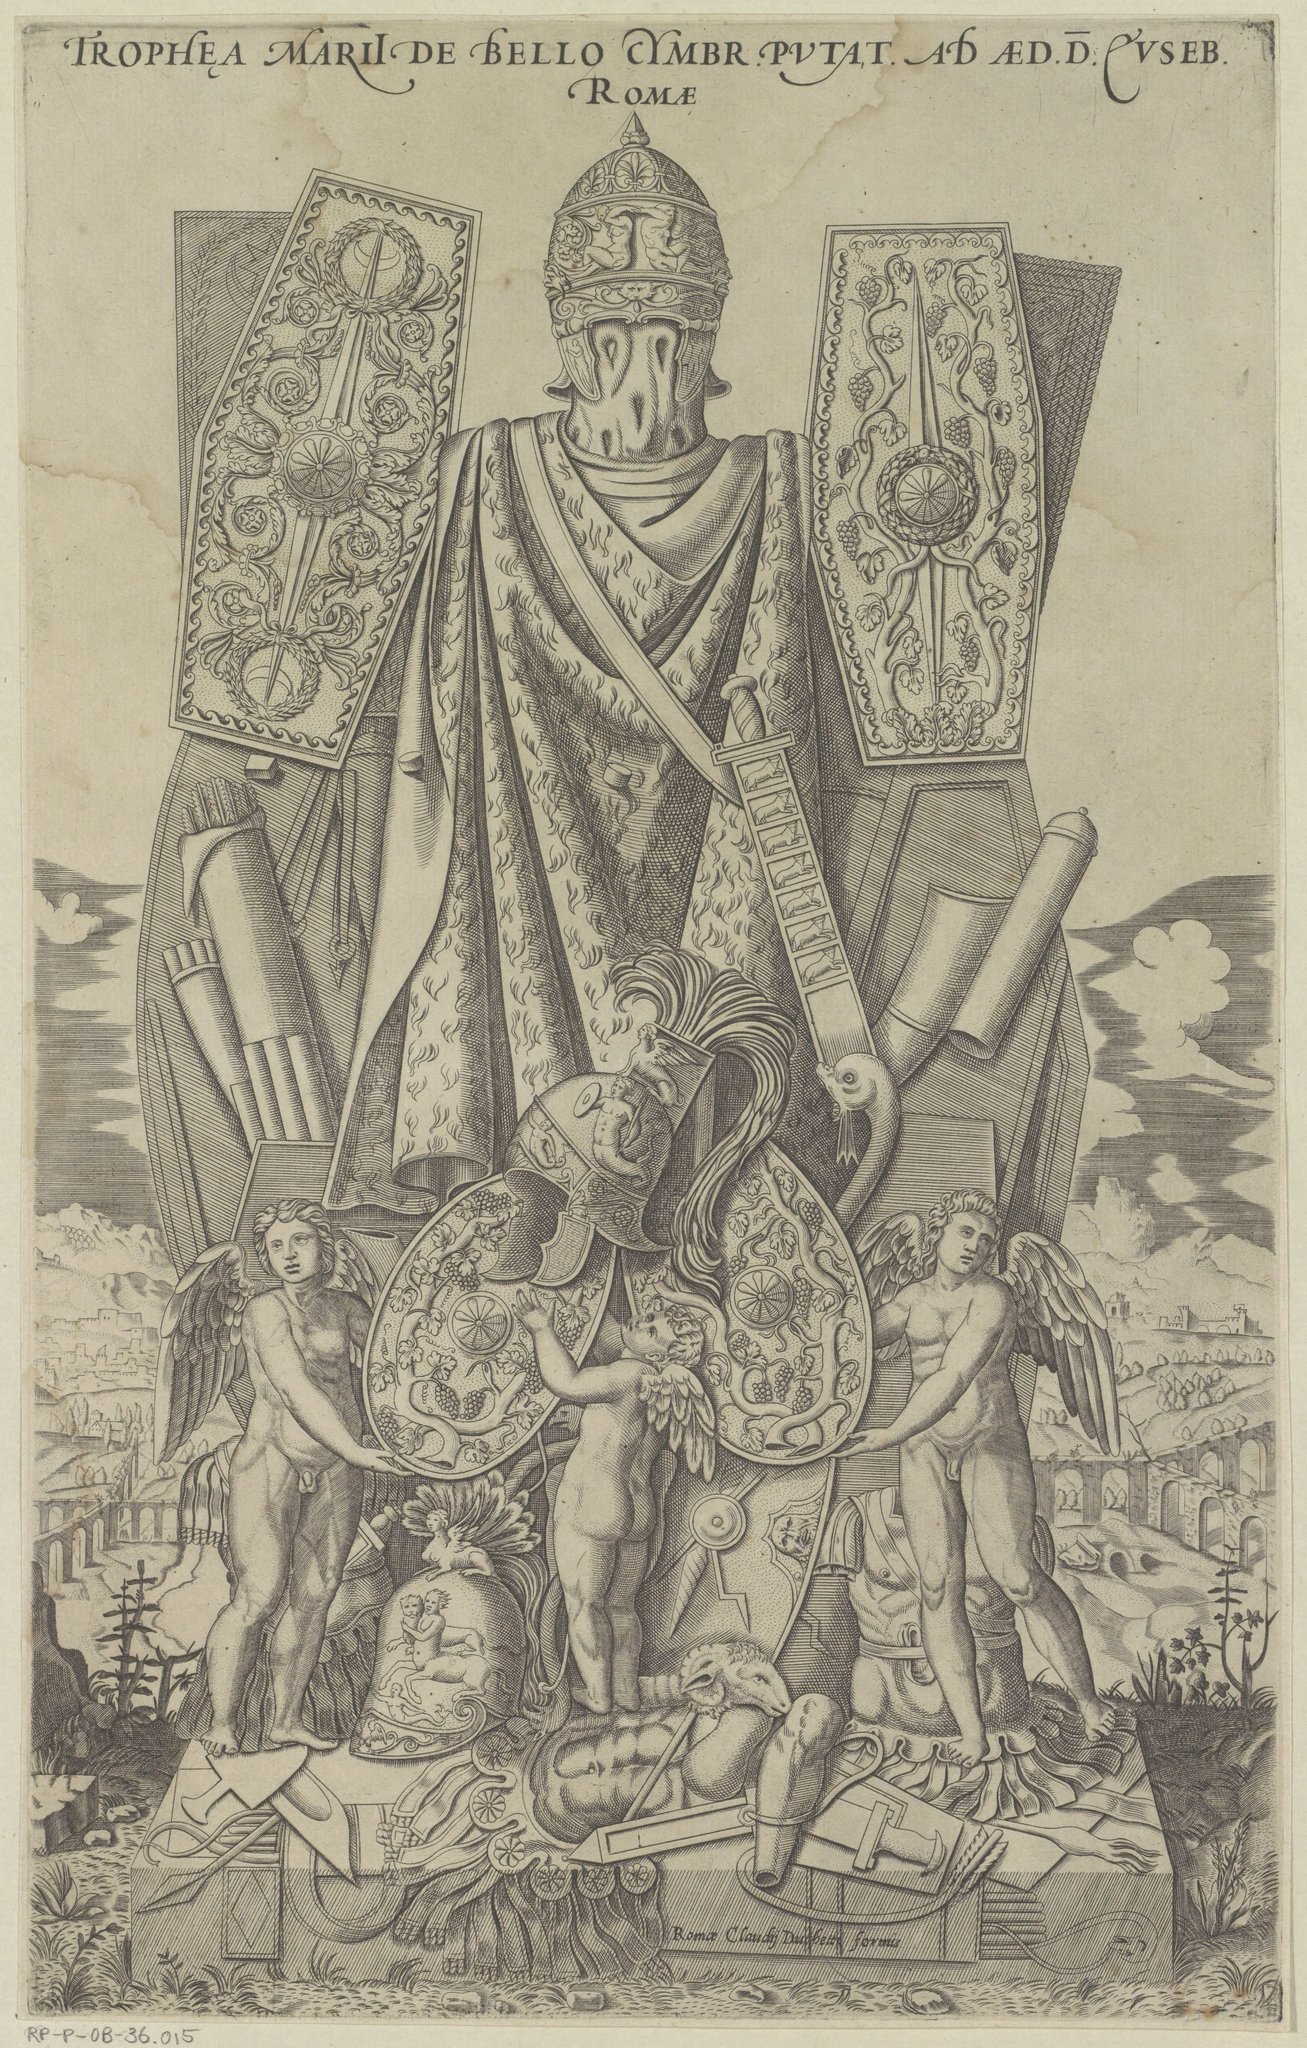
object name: print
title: Oorlogstrofeeën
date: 1572-1585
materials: paper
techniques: engraving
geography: rome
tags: trophy ~ battle, war, cupids: 'amores', 'amoretti', 'putti'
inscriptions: collector's mark: Lugt 240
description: Deze prent behoort tot het prentcorpus dat bekend staat als de ‘Speculum Romanae Magnificentiae’ (‘Spiegel van Romeinse pracht’). Dit corpus, bestaande uit prenten met voorstellingen van kunstwerken en gebouwen uit het antieke en het moderne Rome, vond zijn oorsprong bij uitgevers Antonio Salamanca en Antonio Lafreri. Deze twee buitenlandse uitgevers bundelden hun krachten te Rome in de periode 1553-1563. Hun prenten werden al snel razend populair bij toeristen en verzamelaars, die de prenten individueel of in grote groepen aanschaften. Grote groepen Speculum-prenten werden vaak op aanvraag samengebonden in albums. Er zijn verschillende Speculum-albums overgeleverd die allemaal verschillen van inhoud. Tussen 1573 en 1577 gaf Antonio Lafreri een speciale titelpagina uit (met de titel ‘Speculum Romanae Magnificentiae’) die mensen voor hun verzamelingen konden voegen. Het overlijden van Lafreri in 1577 betekende niet het einde van het corpus. Een groot deel van de koperplaten ging over op Claudio en Stefano Duchetti. De rest raakte verspreid over verschillende andere uitgevers. De populariteit van de Speculum-prenten wist nog geruime periode uitgevers te inspireren tot het laten maken van kopieën en het toevoegen van nieuwe prenten aan het corpus.